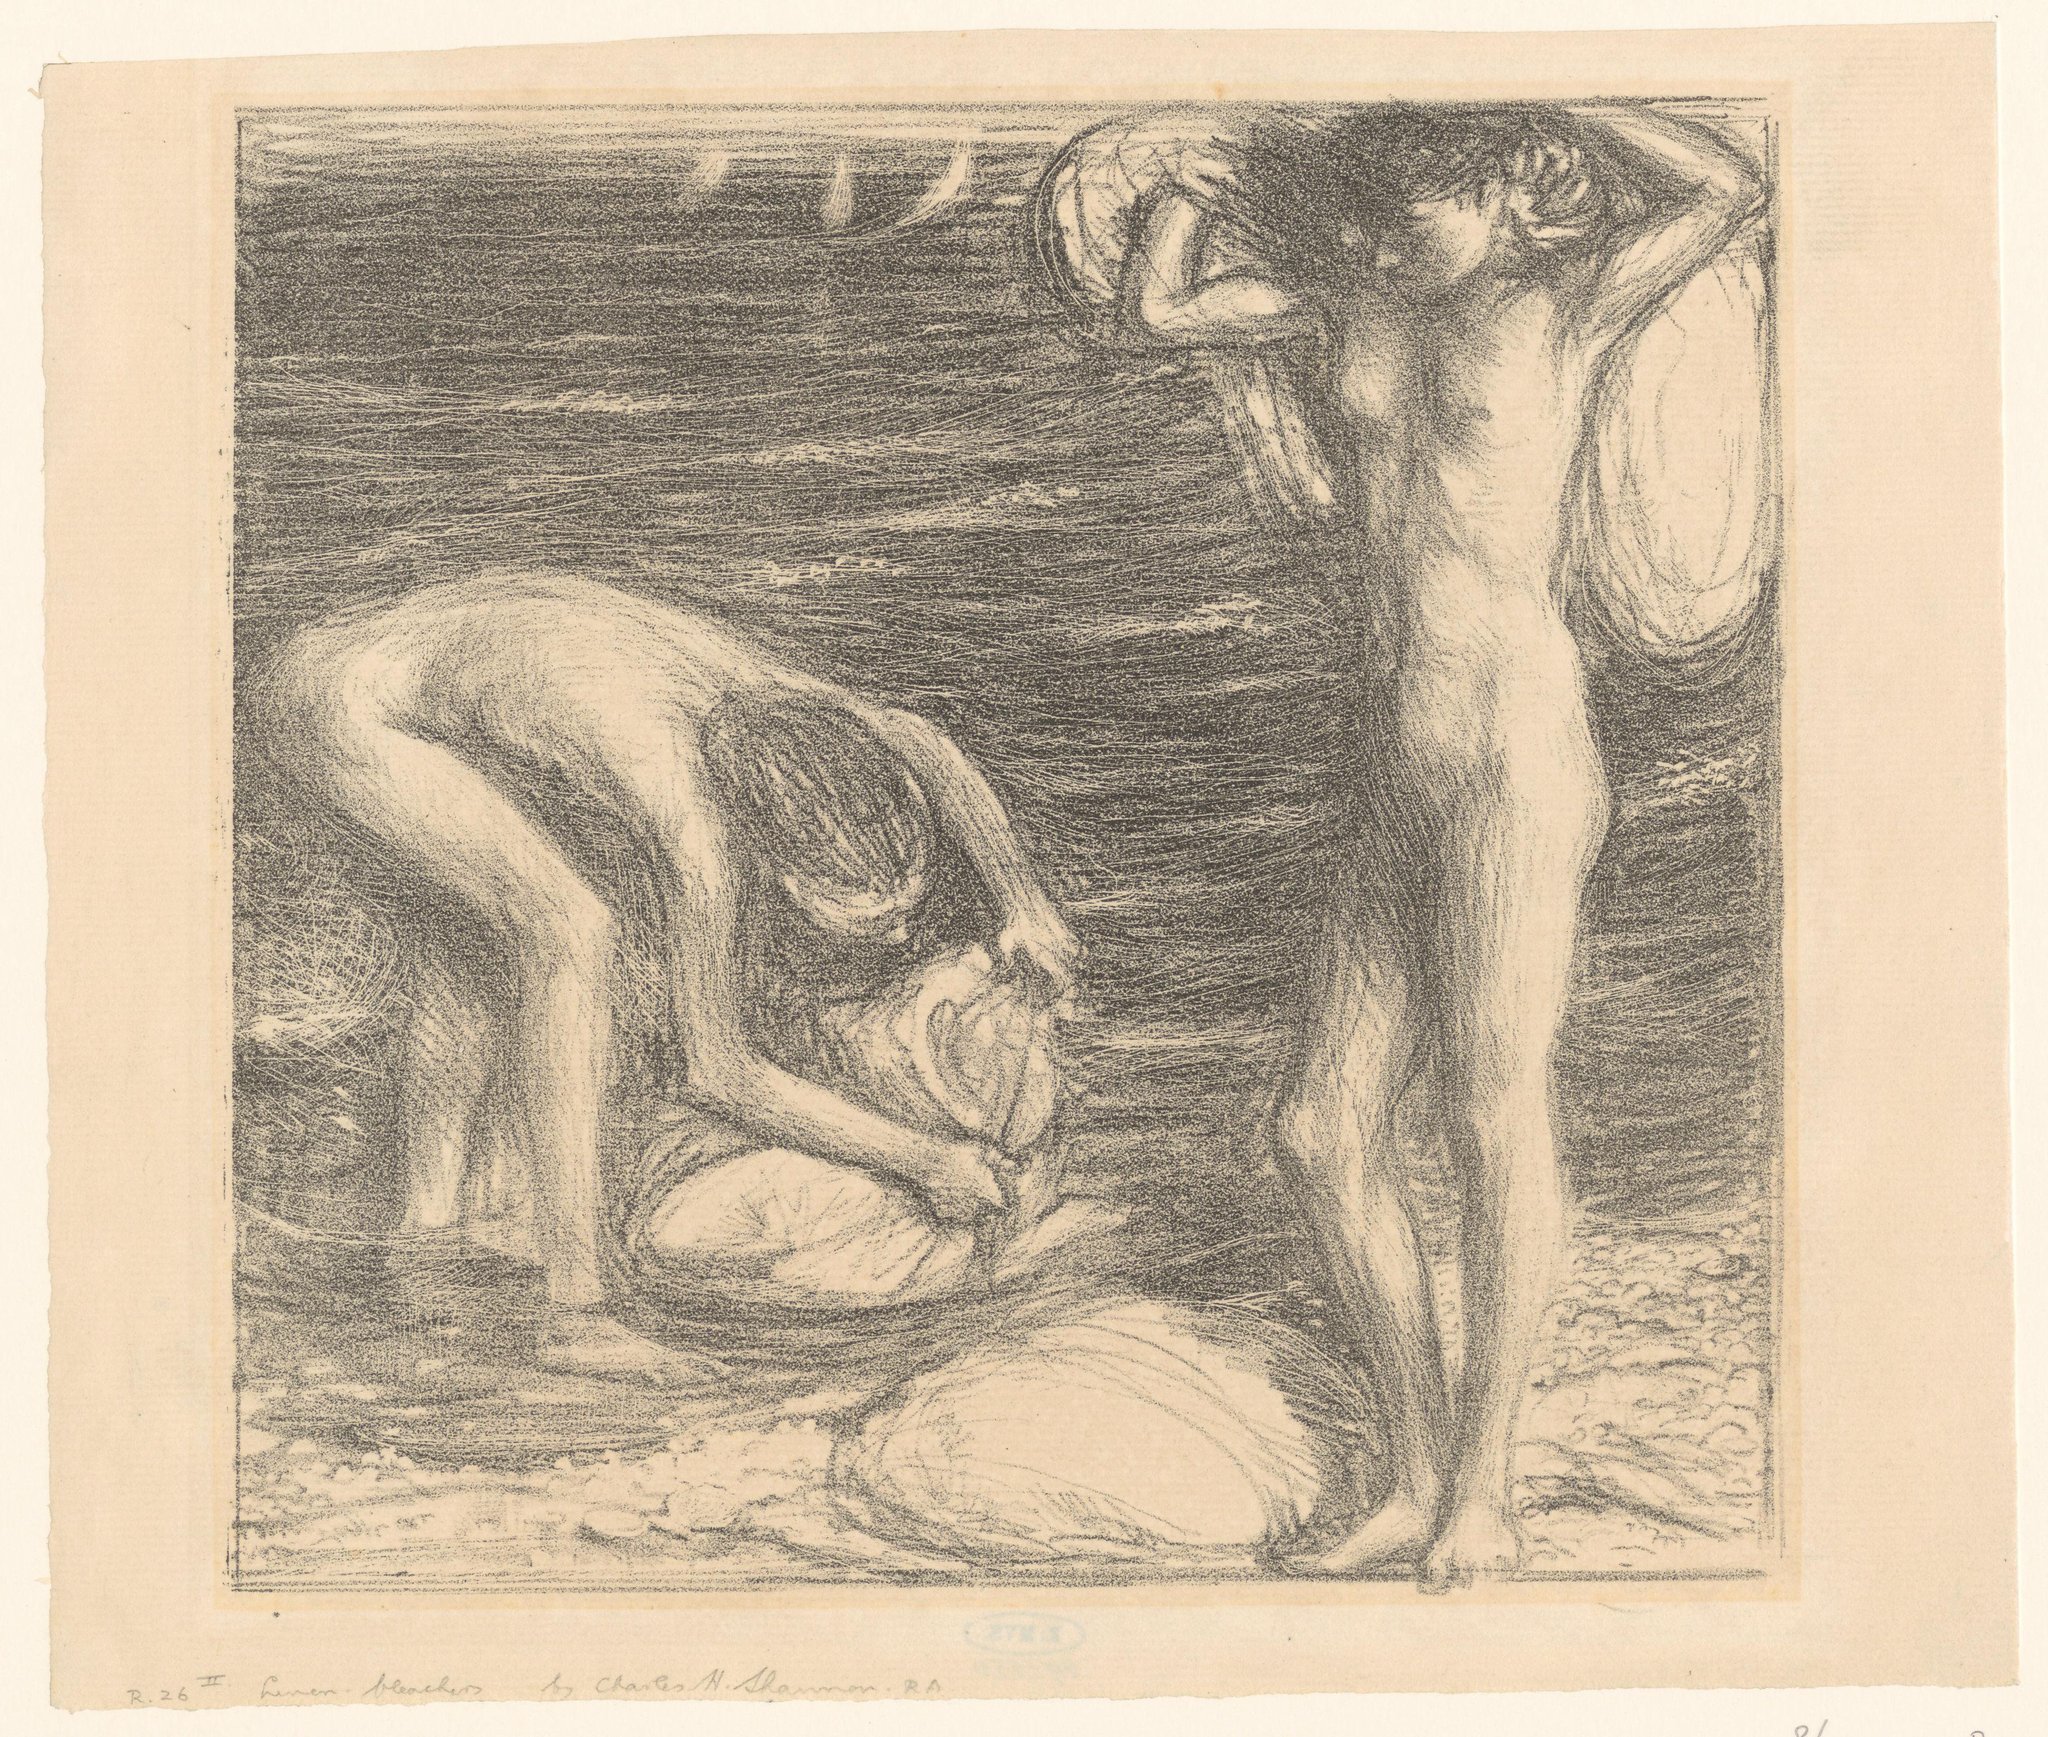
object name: print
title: Twee naakte vrouwen bleken linnen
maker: charles haslewood shannon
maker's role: draughtsman, print maker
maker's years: 1865-1937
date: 1894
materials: paper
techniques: lithograph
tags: bleaching (laundering), adult woman (+ two persons), the (nude) human figure; 'corpo humano' (ripa) - aa - female human figure, sea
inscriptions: collector's mark: Lugt 2228